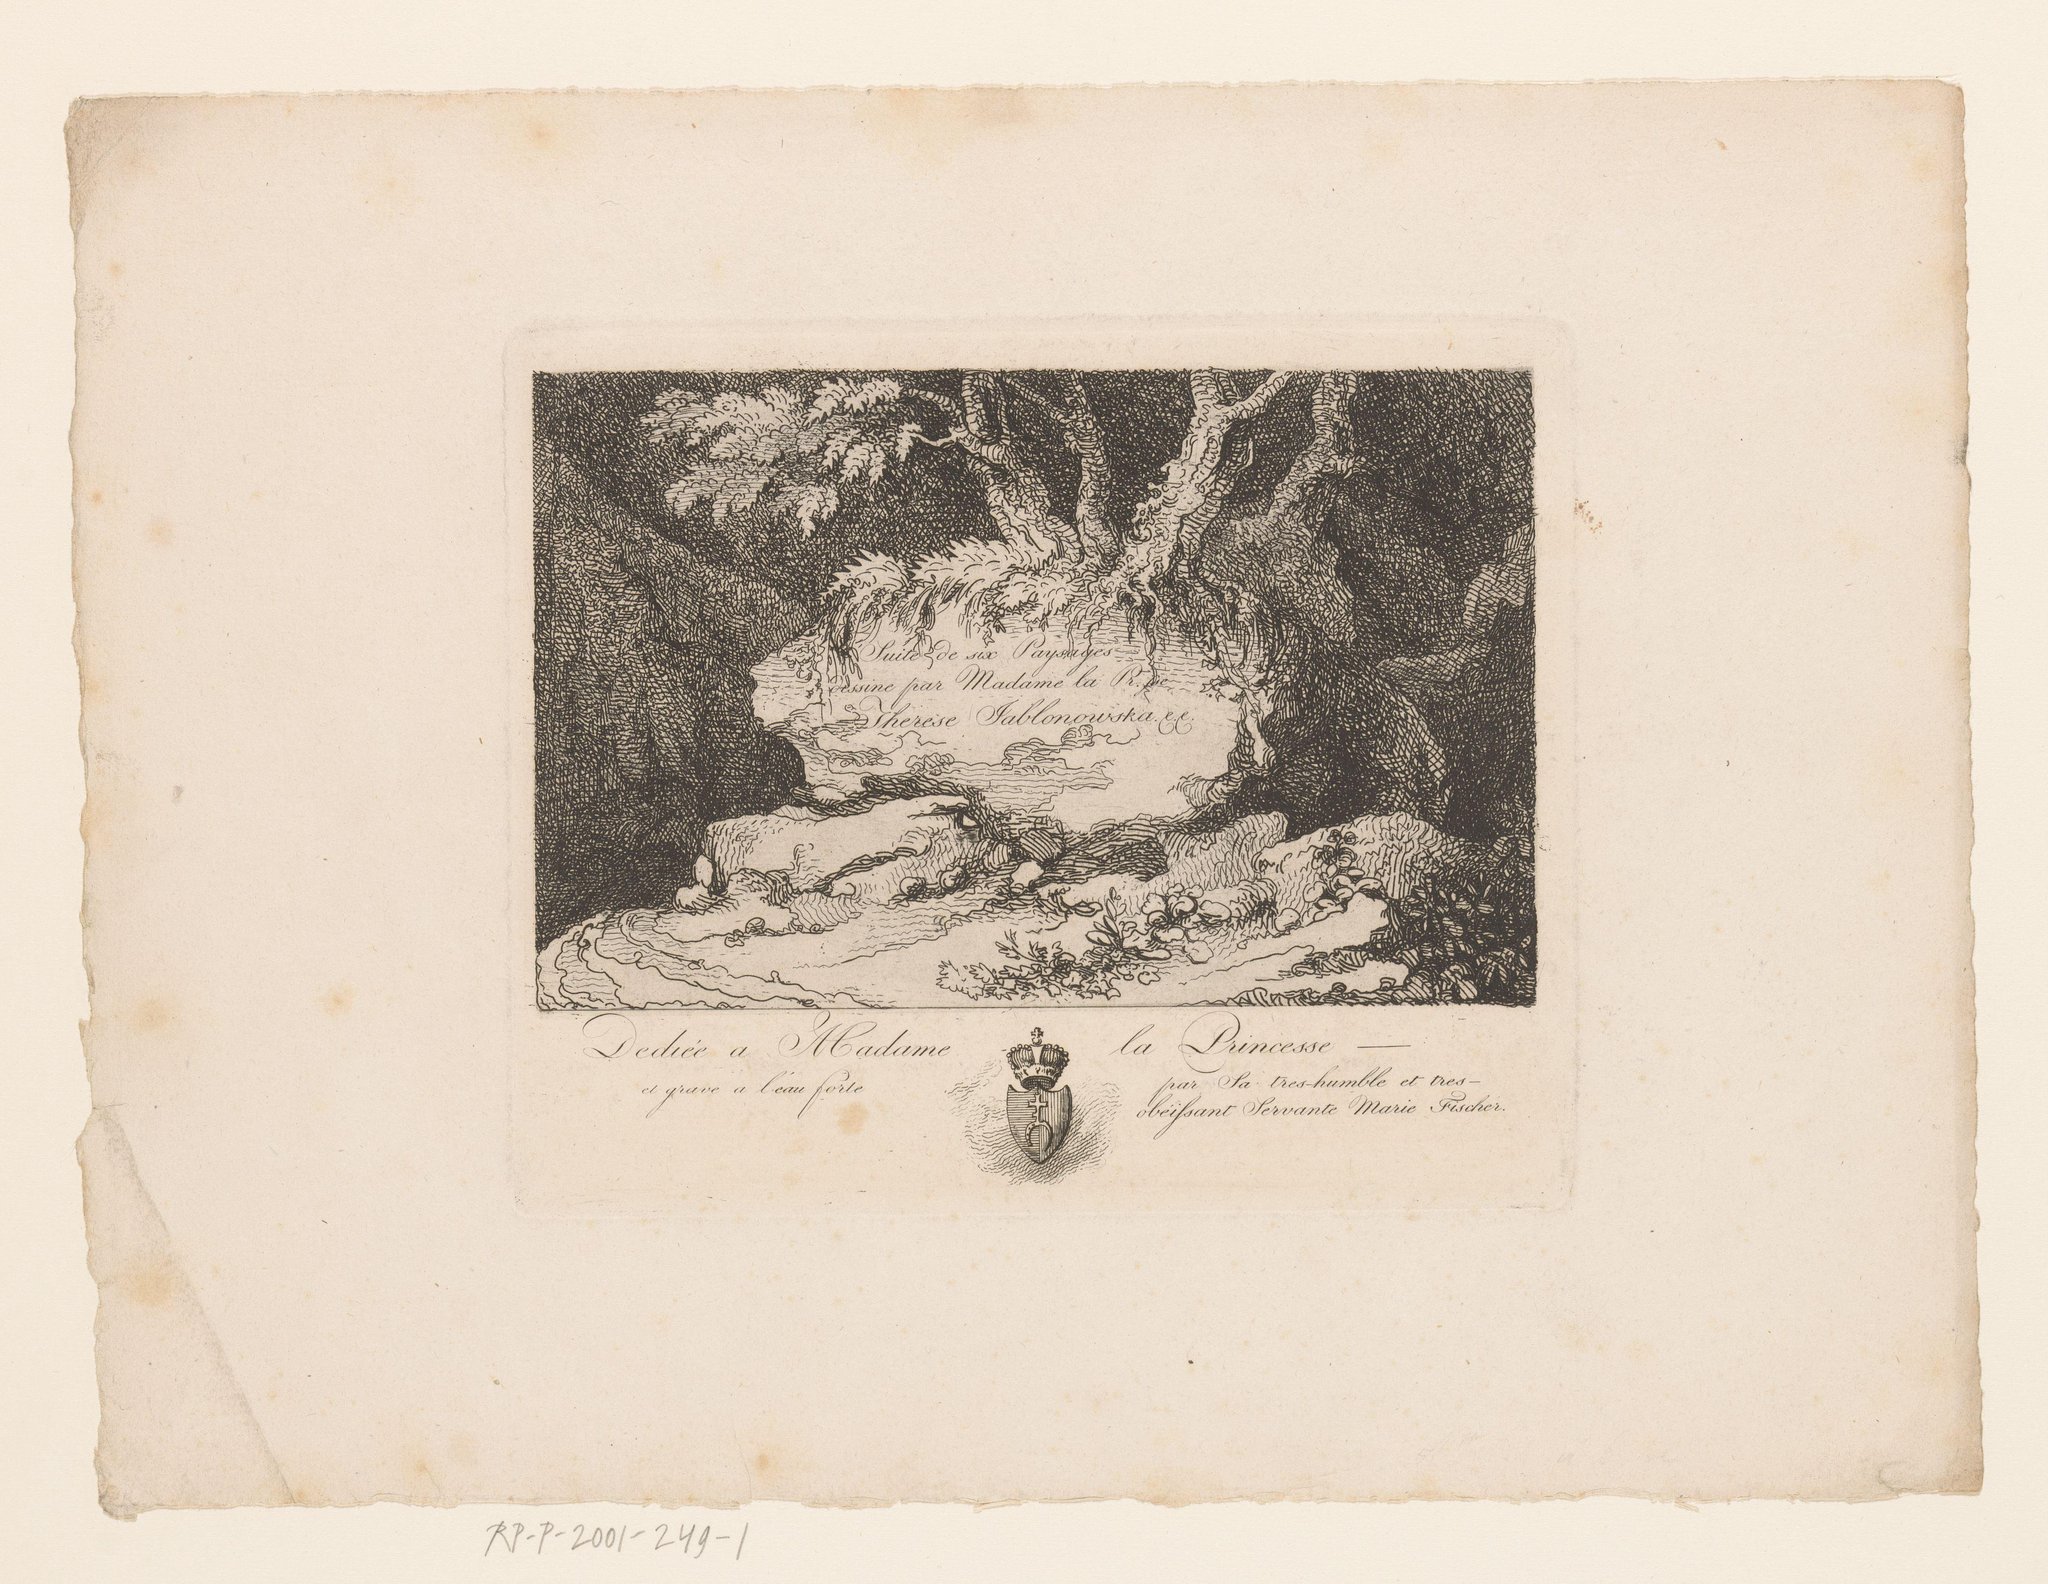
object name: titelprent, frontispice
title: Suite de six paysages dessiné par la Pr. sse Madame Thérèse Jablonowska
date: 1779-1807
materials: paper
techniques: etching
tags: trees (+ root, tuber), rock-formations, armorial bearing, heraldry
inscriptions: collector's mark: Lugt 2228, collector's mark: Lugt 2760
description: Onderdeel van een serie van vijf prenten en een titelprent.